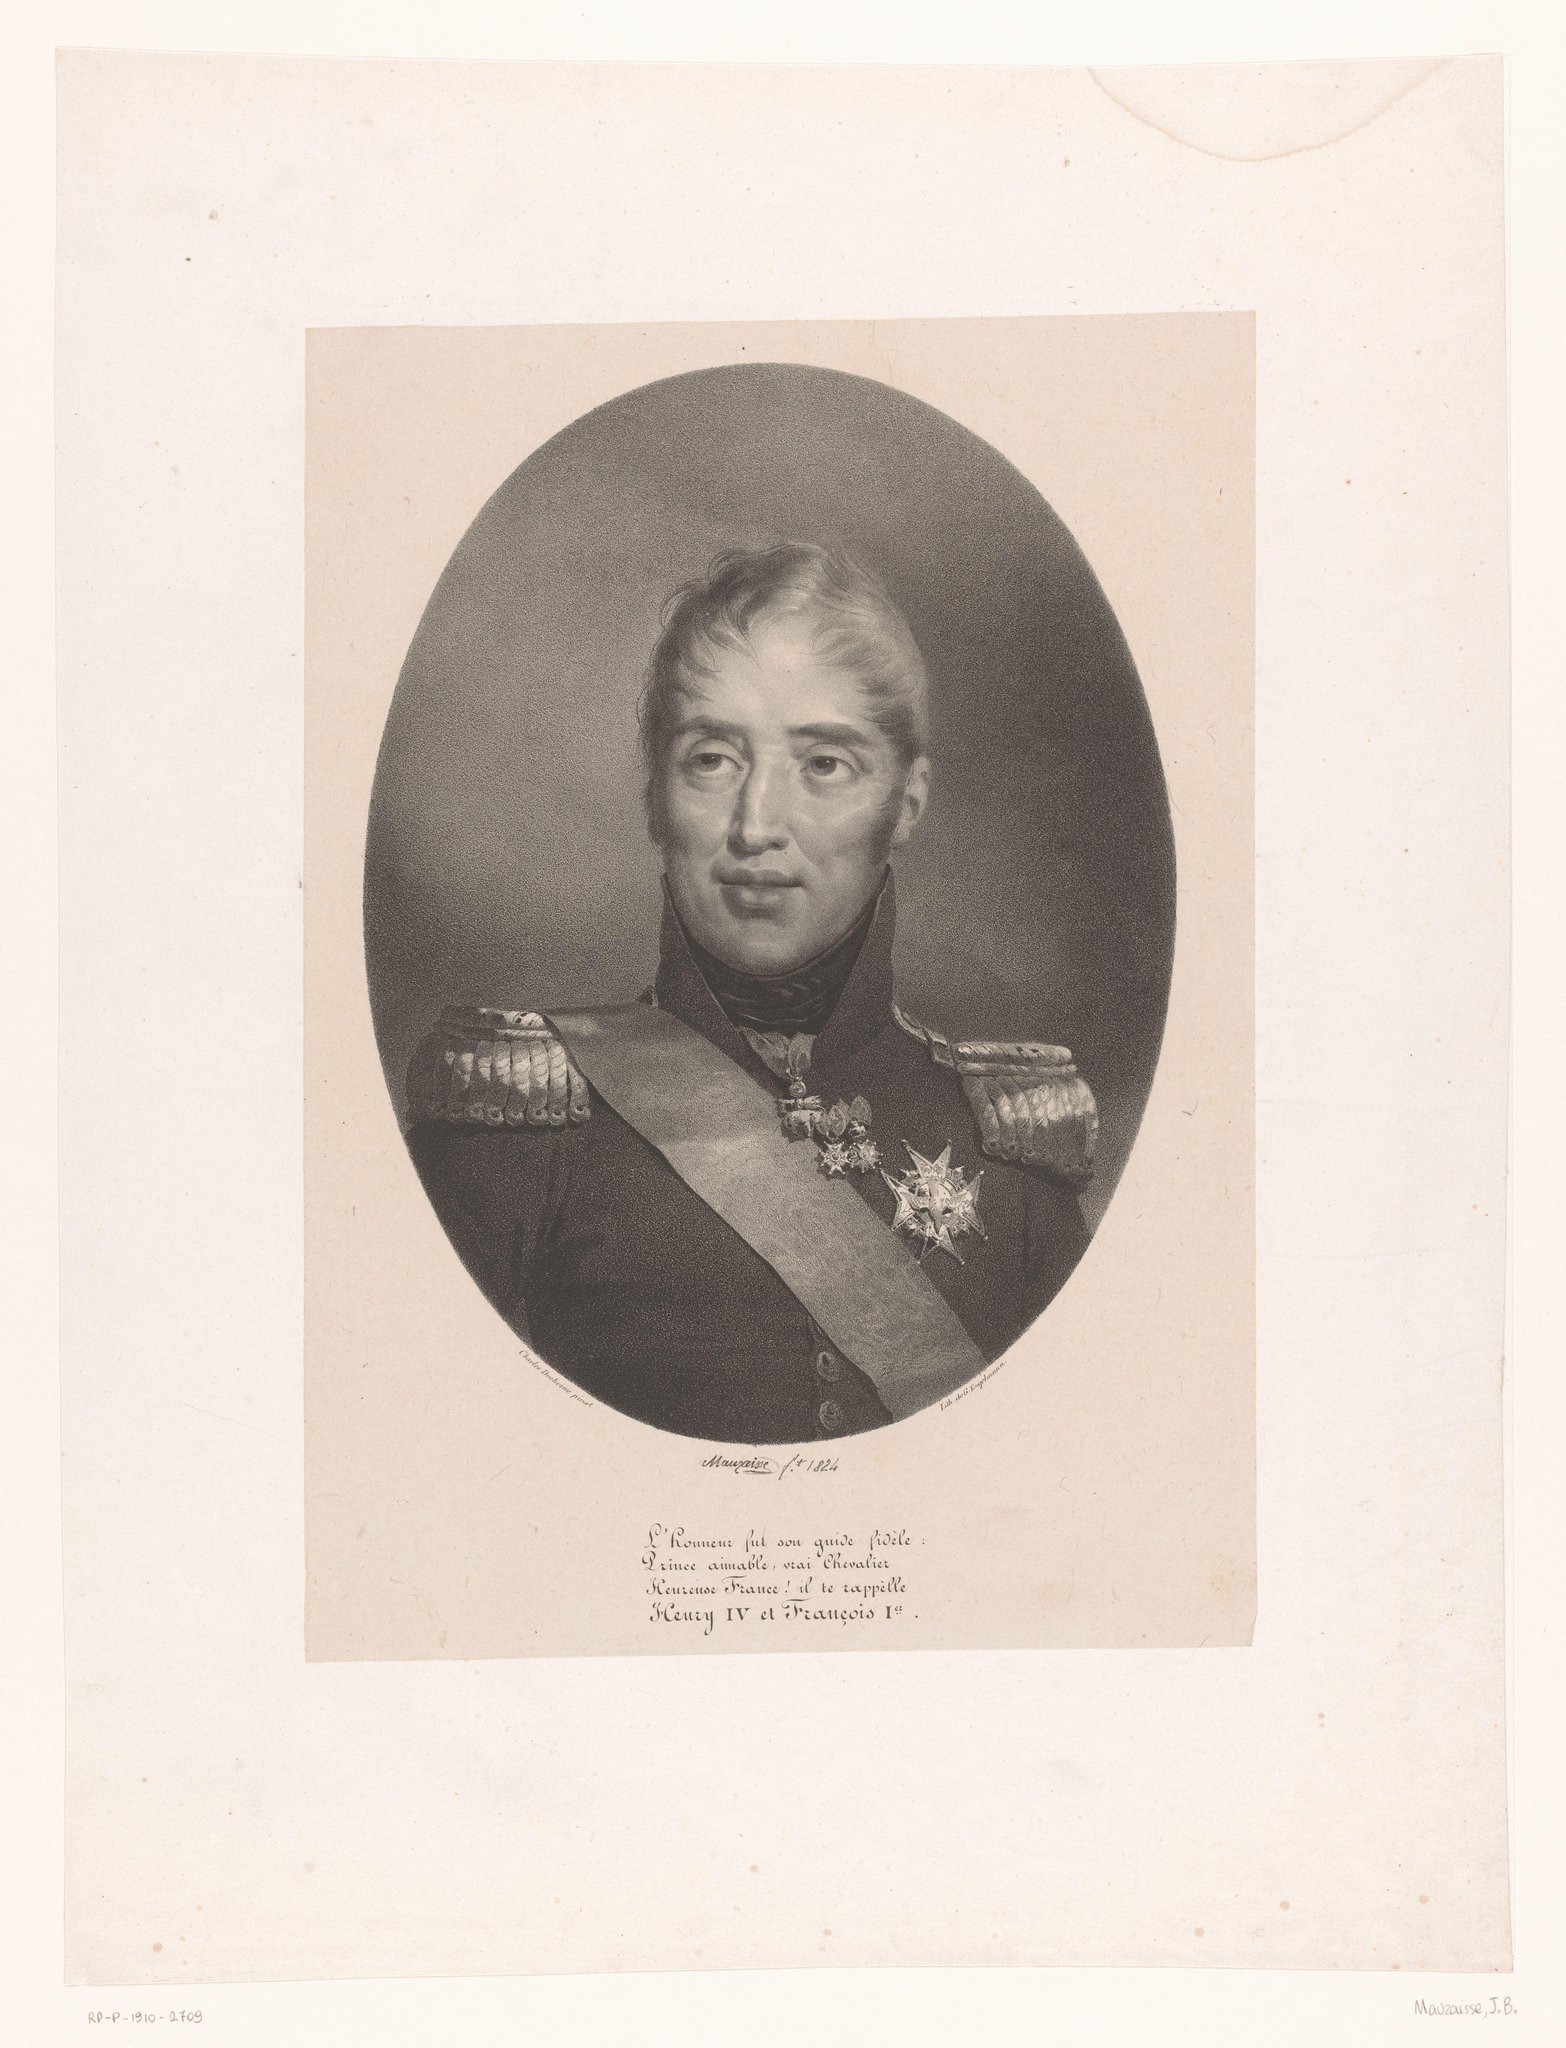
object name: print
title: Portret van Karel X, koning van Frankrijk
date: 1824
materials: paper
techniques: lithograph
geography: paris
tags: historical persons, king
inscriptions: collector's mark: Lugt 2228